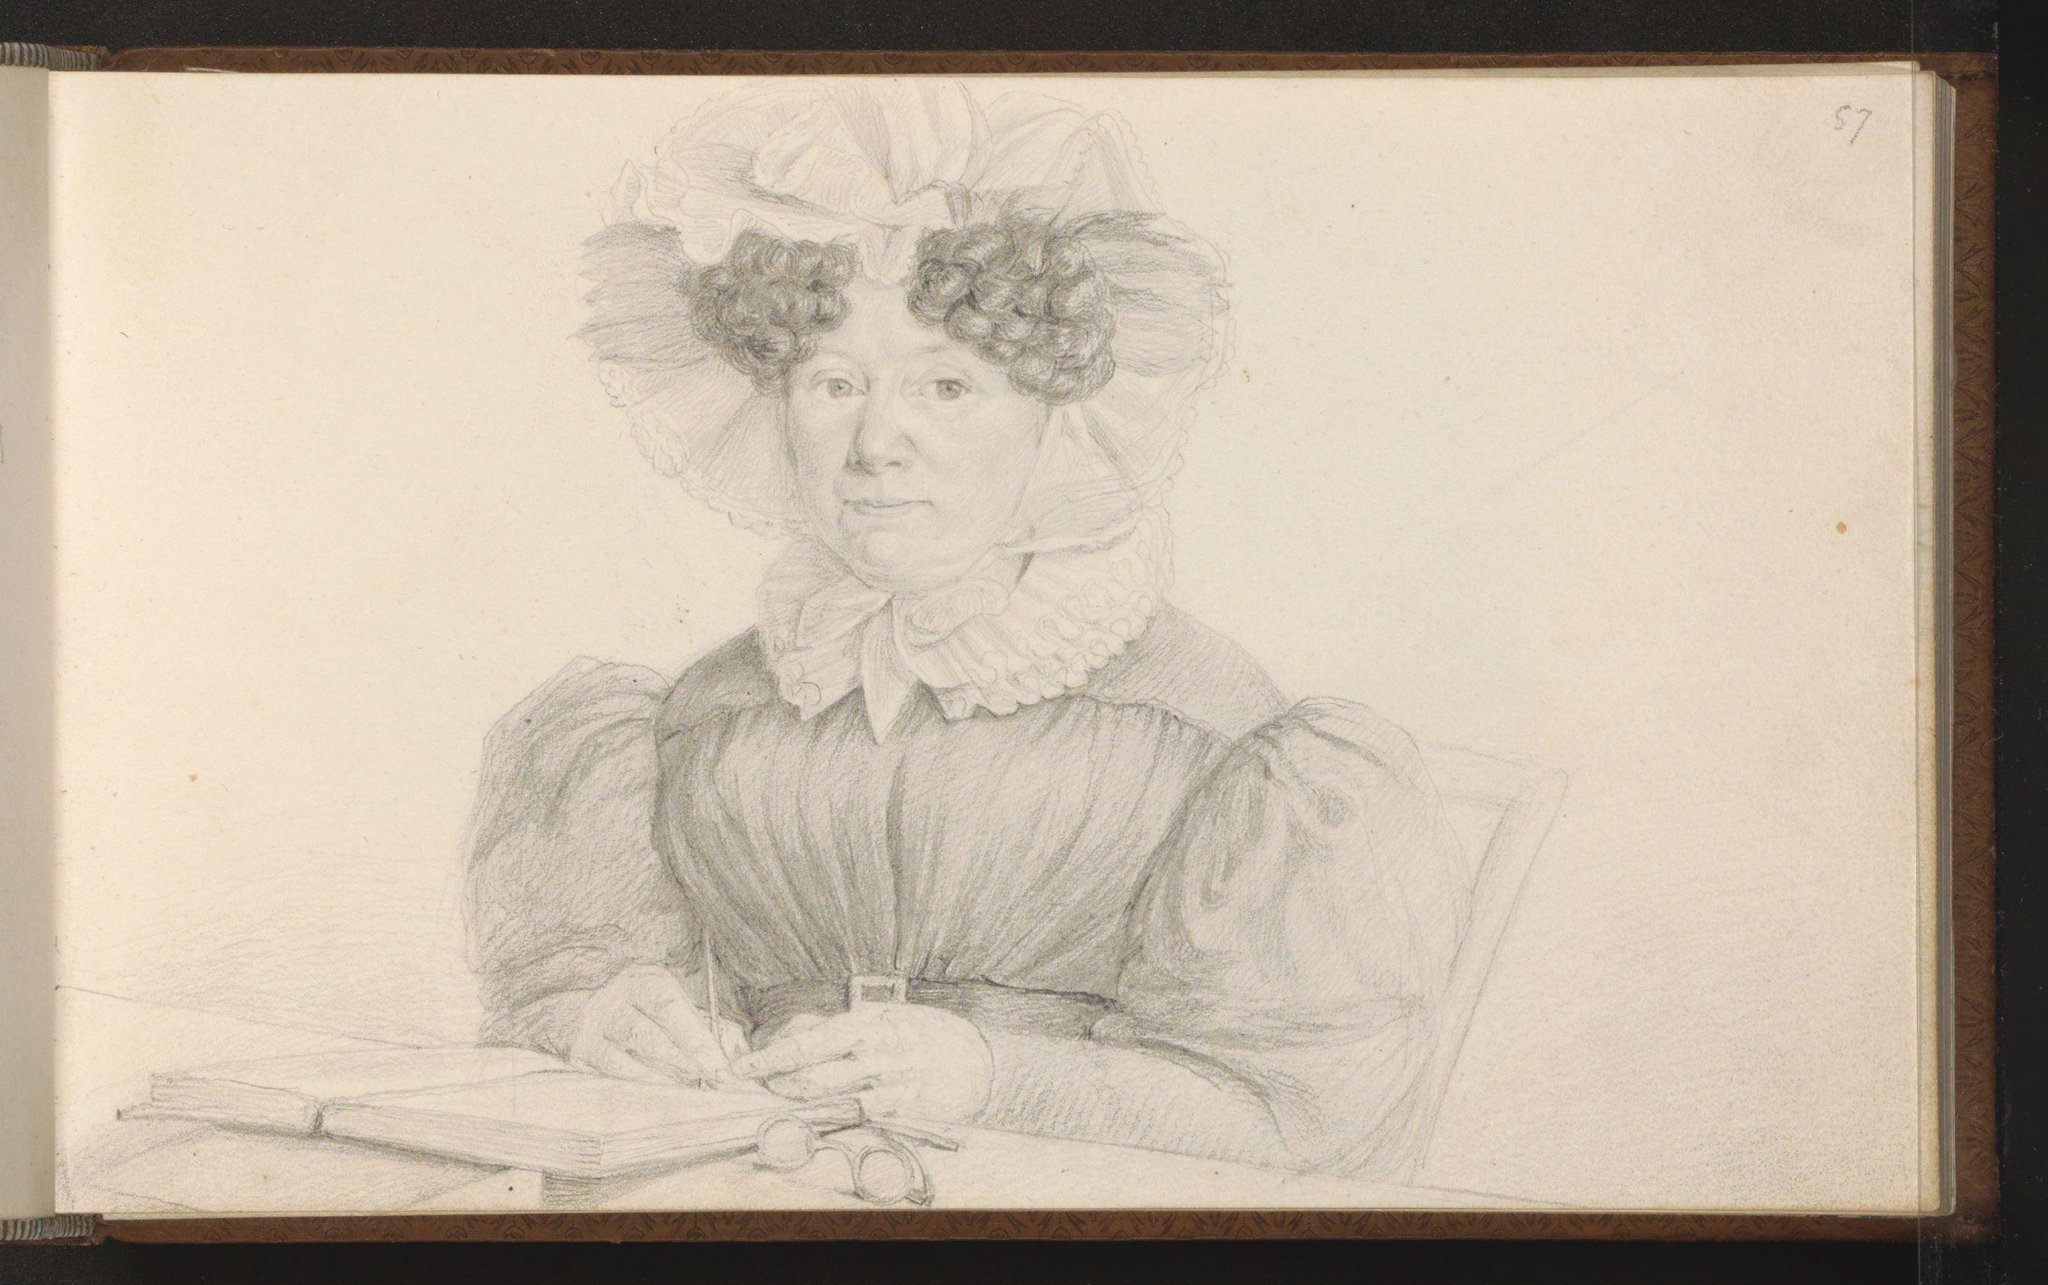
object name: sketchbook leaf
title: Portret van Catharina Elisabeth Spakler-Burmester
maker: christian heinrich gottlieb steuerwald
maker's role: draughtsman, print maker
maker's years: 1802-1874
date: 1834-1844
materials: paper, pencil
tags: amsterdam, writing accessories, historical persons (portraits and scenes from the life)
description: Portret van Spakler zittend aan een tafel met een boek, pen en leesbril. Bladzijde 57 uit een schetsboek met 188 bladzijden.